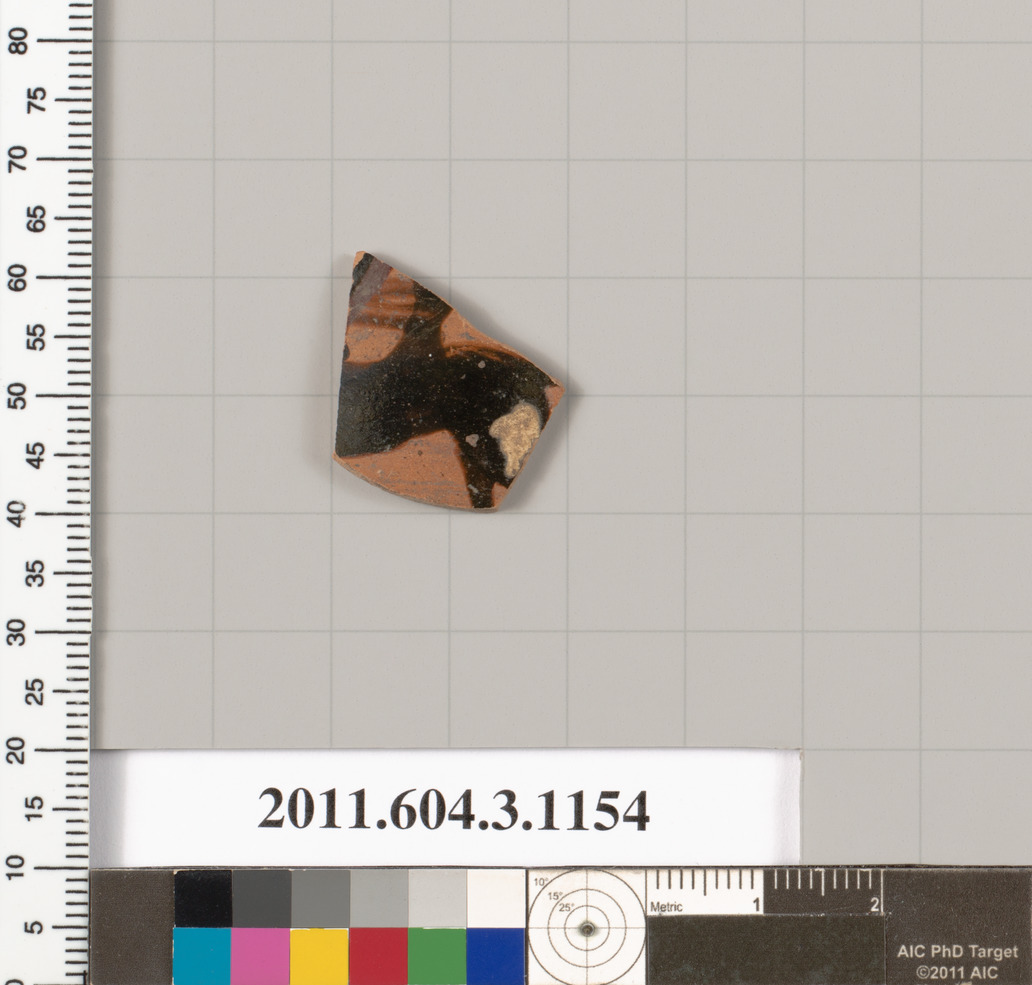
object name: mastoid or kyathos fragment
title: Terracotta fragment of a mastoid (drinking cup with narrow base) or a kyathos (cup-shaped ladle)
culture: greek, attic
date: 534-468 BCE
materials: terracotta